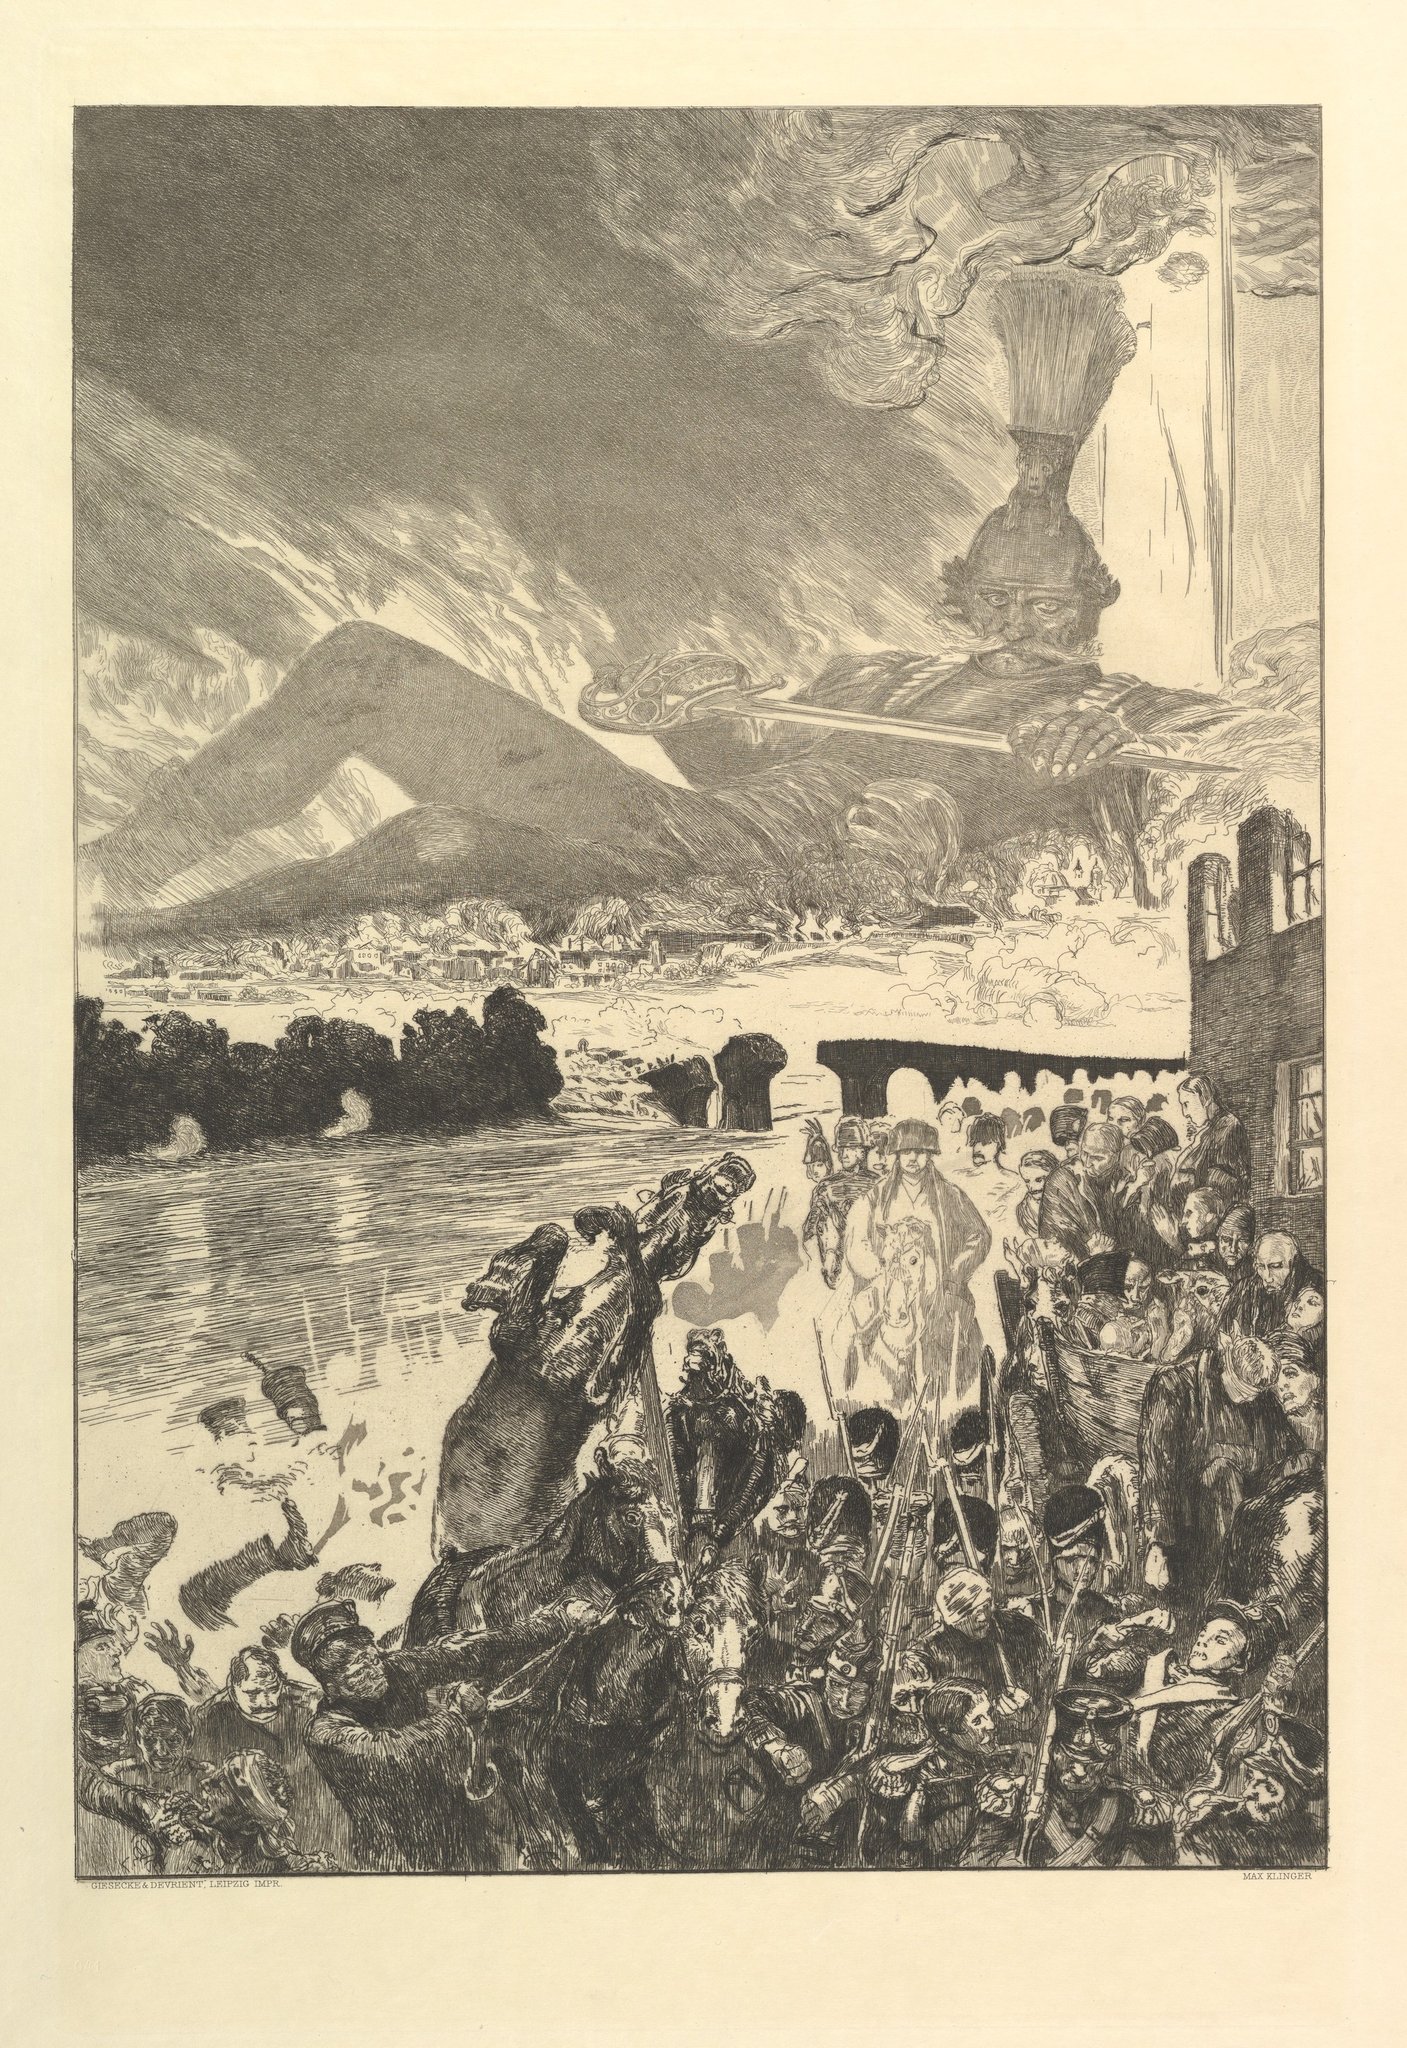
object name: print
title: Krieg, from the series Vom Tode Zweiter Teil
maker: max klinger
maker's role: artist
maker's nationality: german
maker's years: 1857-1920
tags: soldiers,men,horses